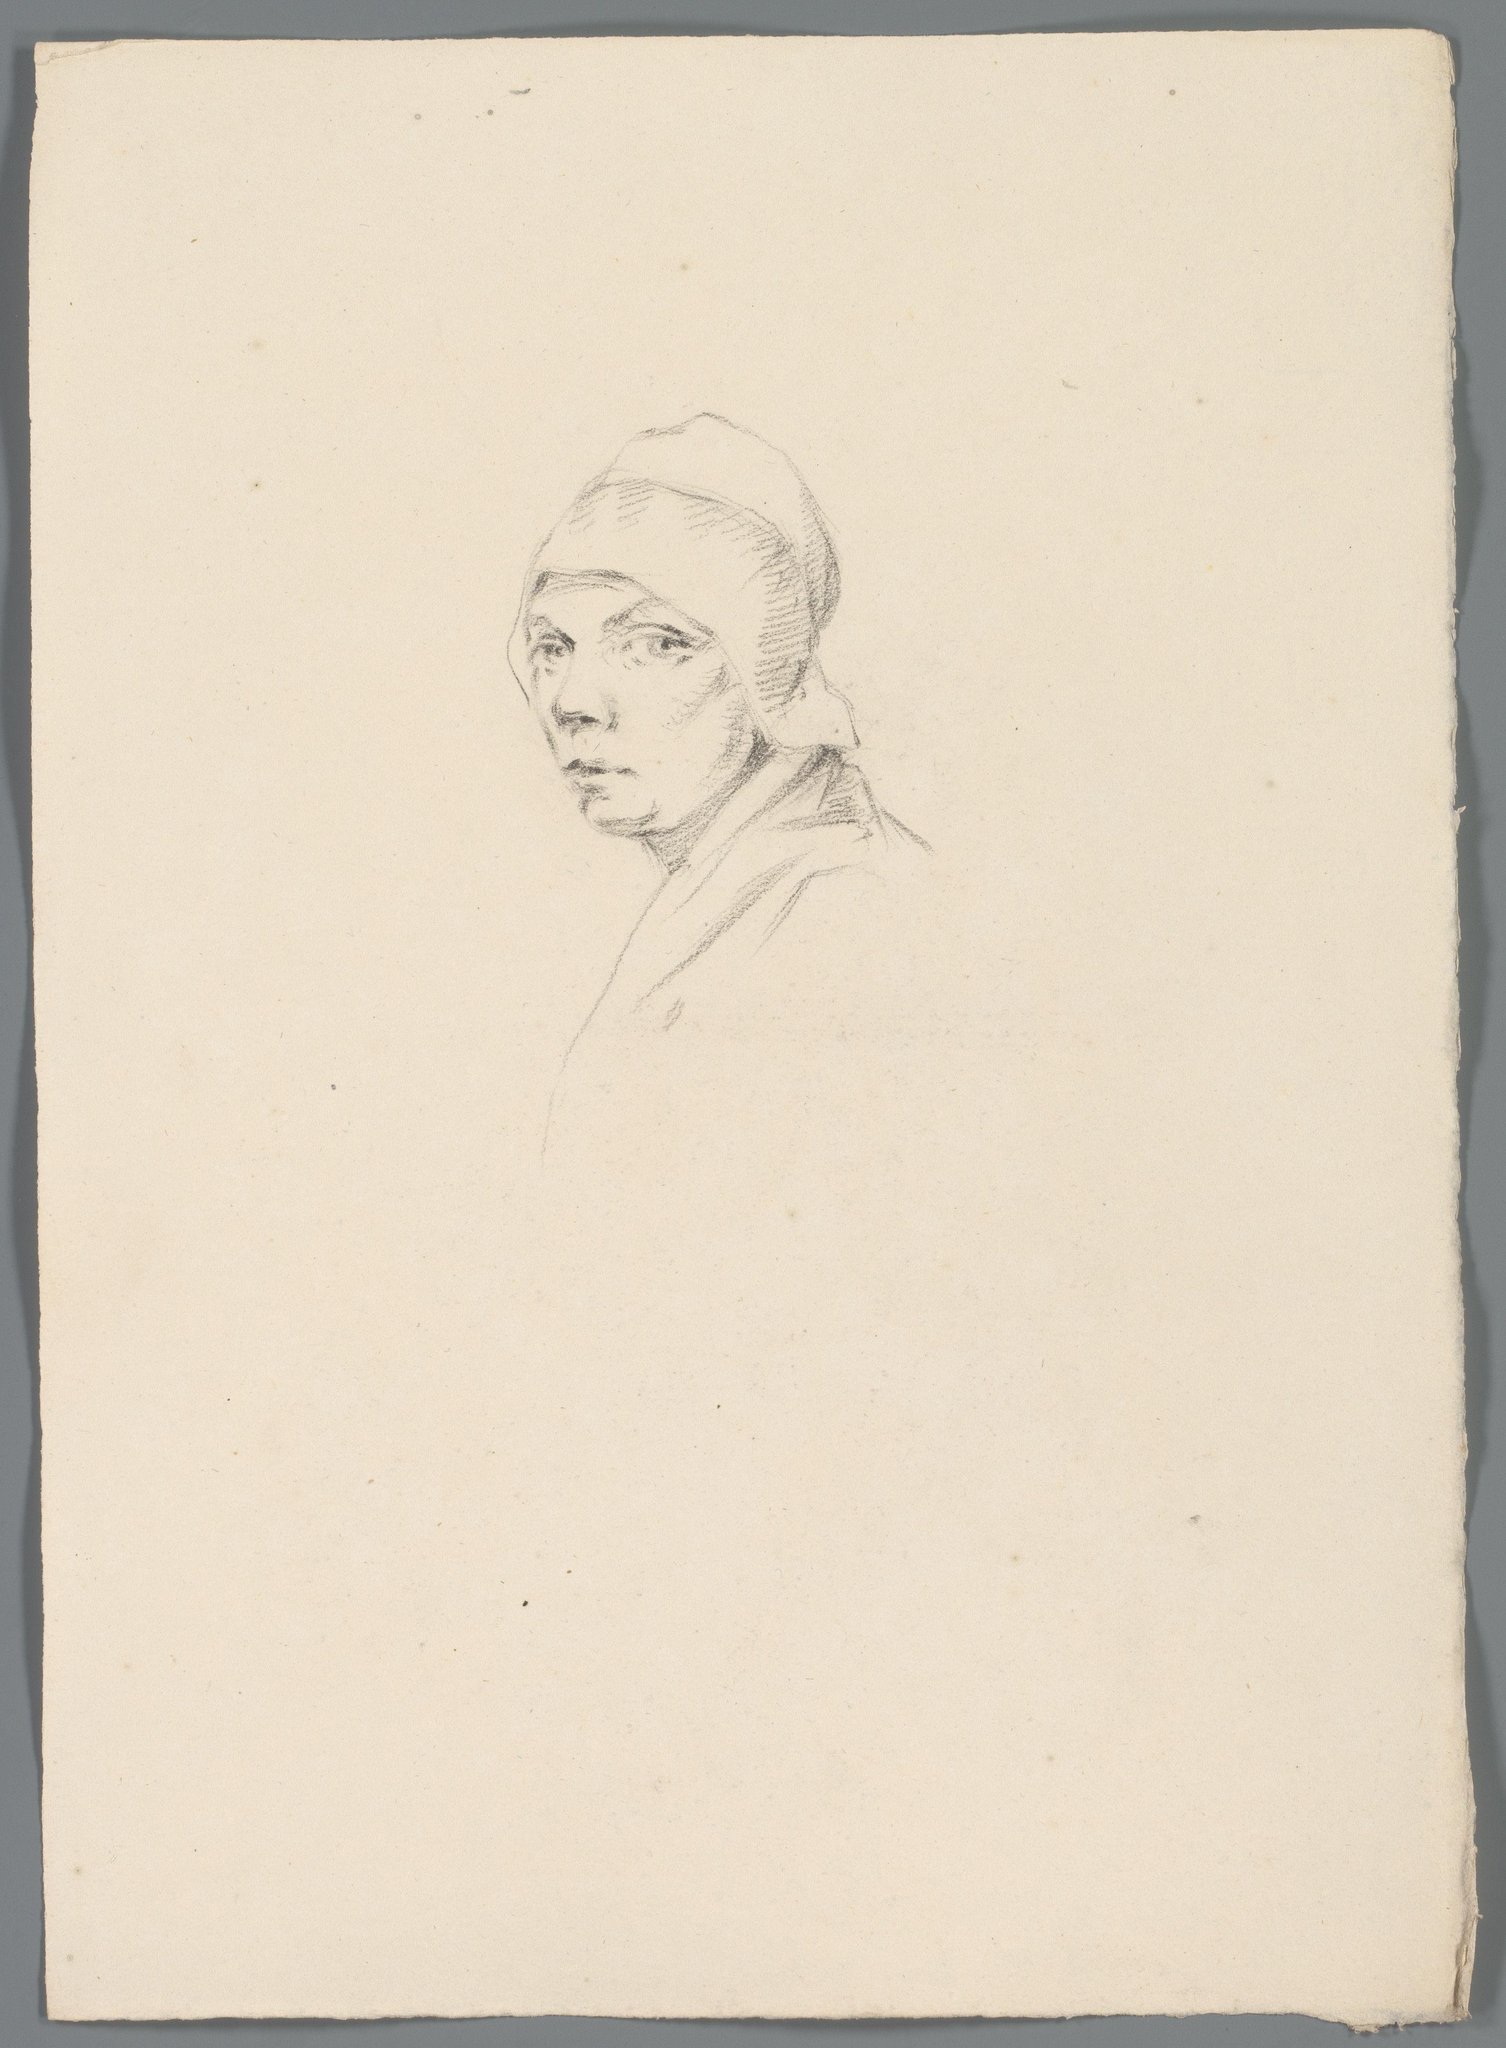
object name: drawing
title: Portret van een onbekende vrouw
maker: Anonymous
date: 1820-1830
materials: chalk, paper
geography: the hague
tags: historical persons not known by name - bb - woman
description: Tekeningen waarschijnlijk ontstaan bij het Haagse kunstgenootschap ‘Tot Nut der Tekenkunst’, waar twee keer per week tekenavonden werden georganiseerd met geklede modellen.